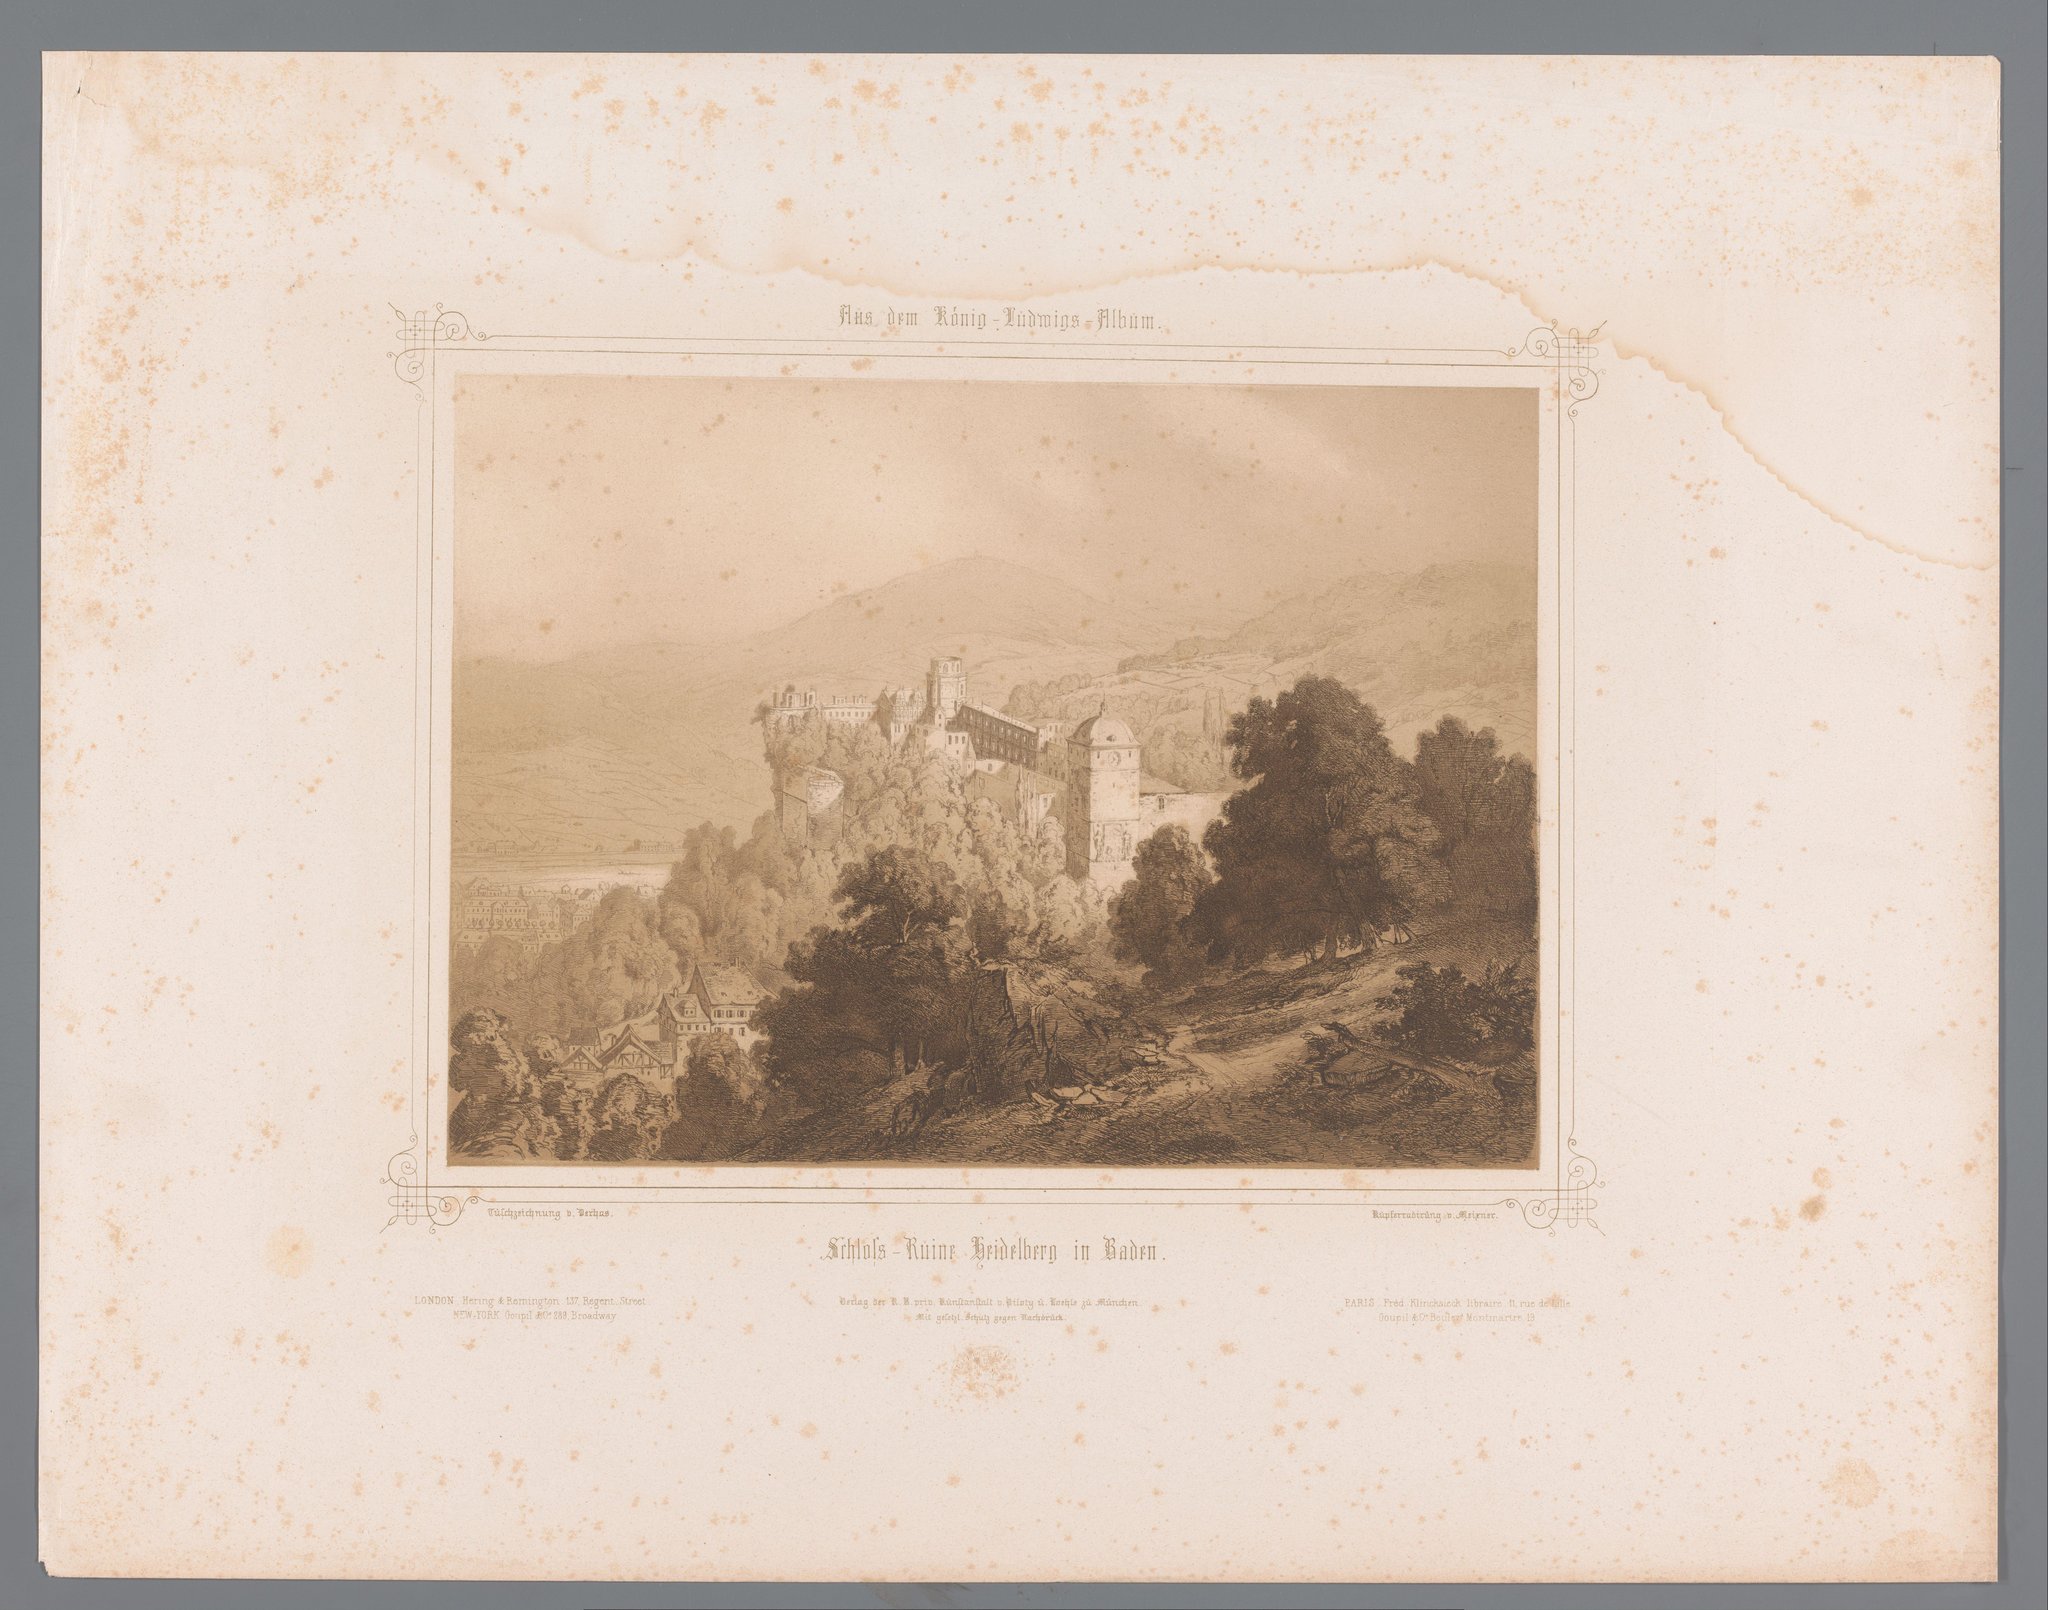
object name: print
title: Album aangeboden aan Lodewijk I van Beieren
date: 1850-1859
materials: paper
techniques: etching, lithograph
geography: london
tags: city-view in general; 'veduta', ruin of a building ~ architecture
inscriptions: collector's mark: Lugt 2228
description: Prent afkomstig uit de serie 'Album Seiner Majestät des Königs Ludwig I. von Bayern', verschenen in verschillende afleveringen. De prenten gaan terug op het album dat Lodewijk I van Beieren op 9 oktober 1850 kreeg overhandigd van verschillende kunstenaars.